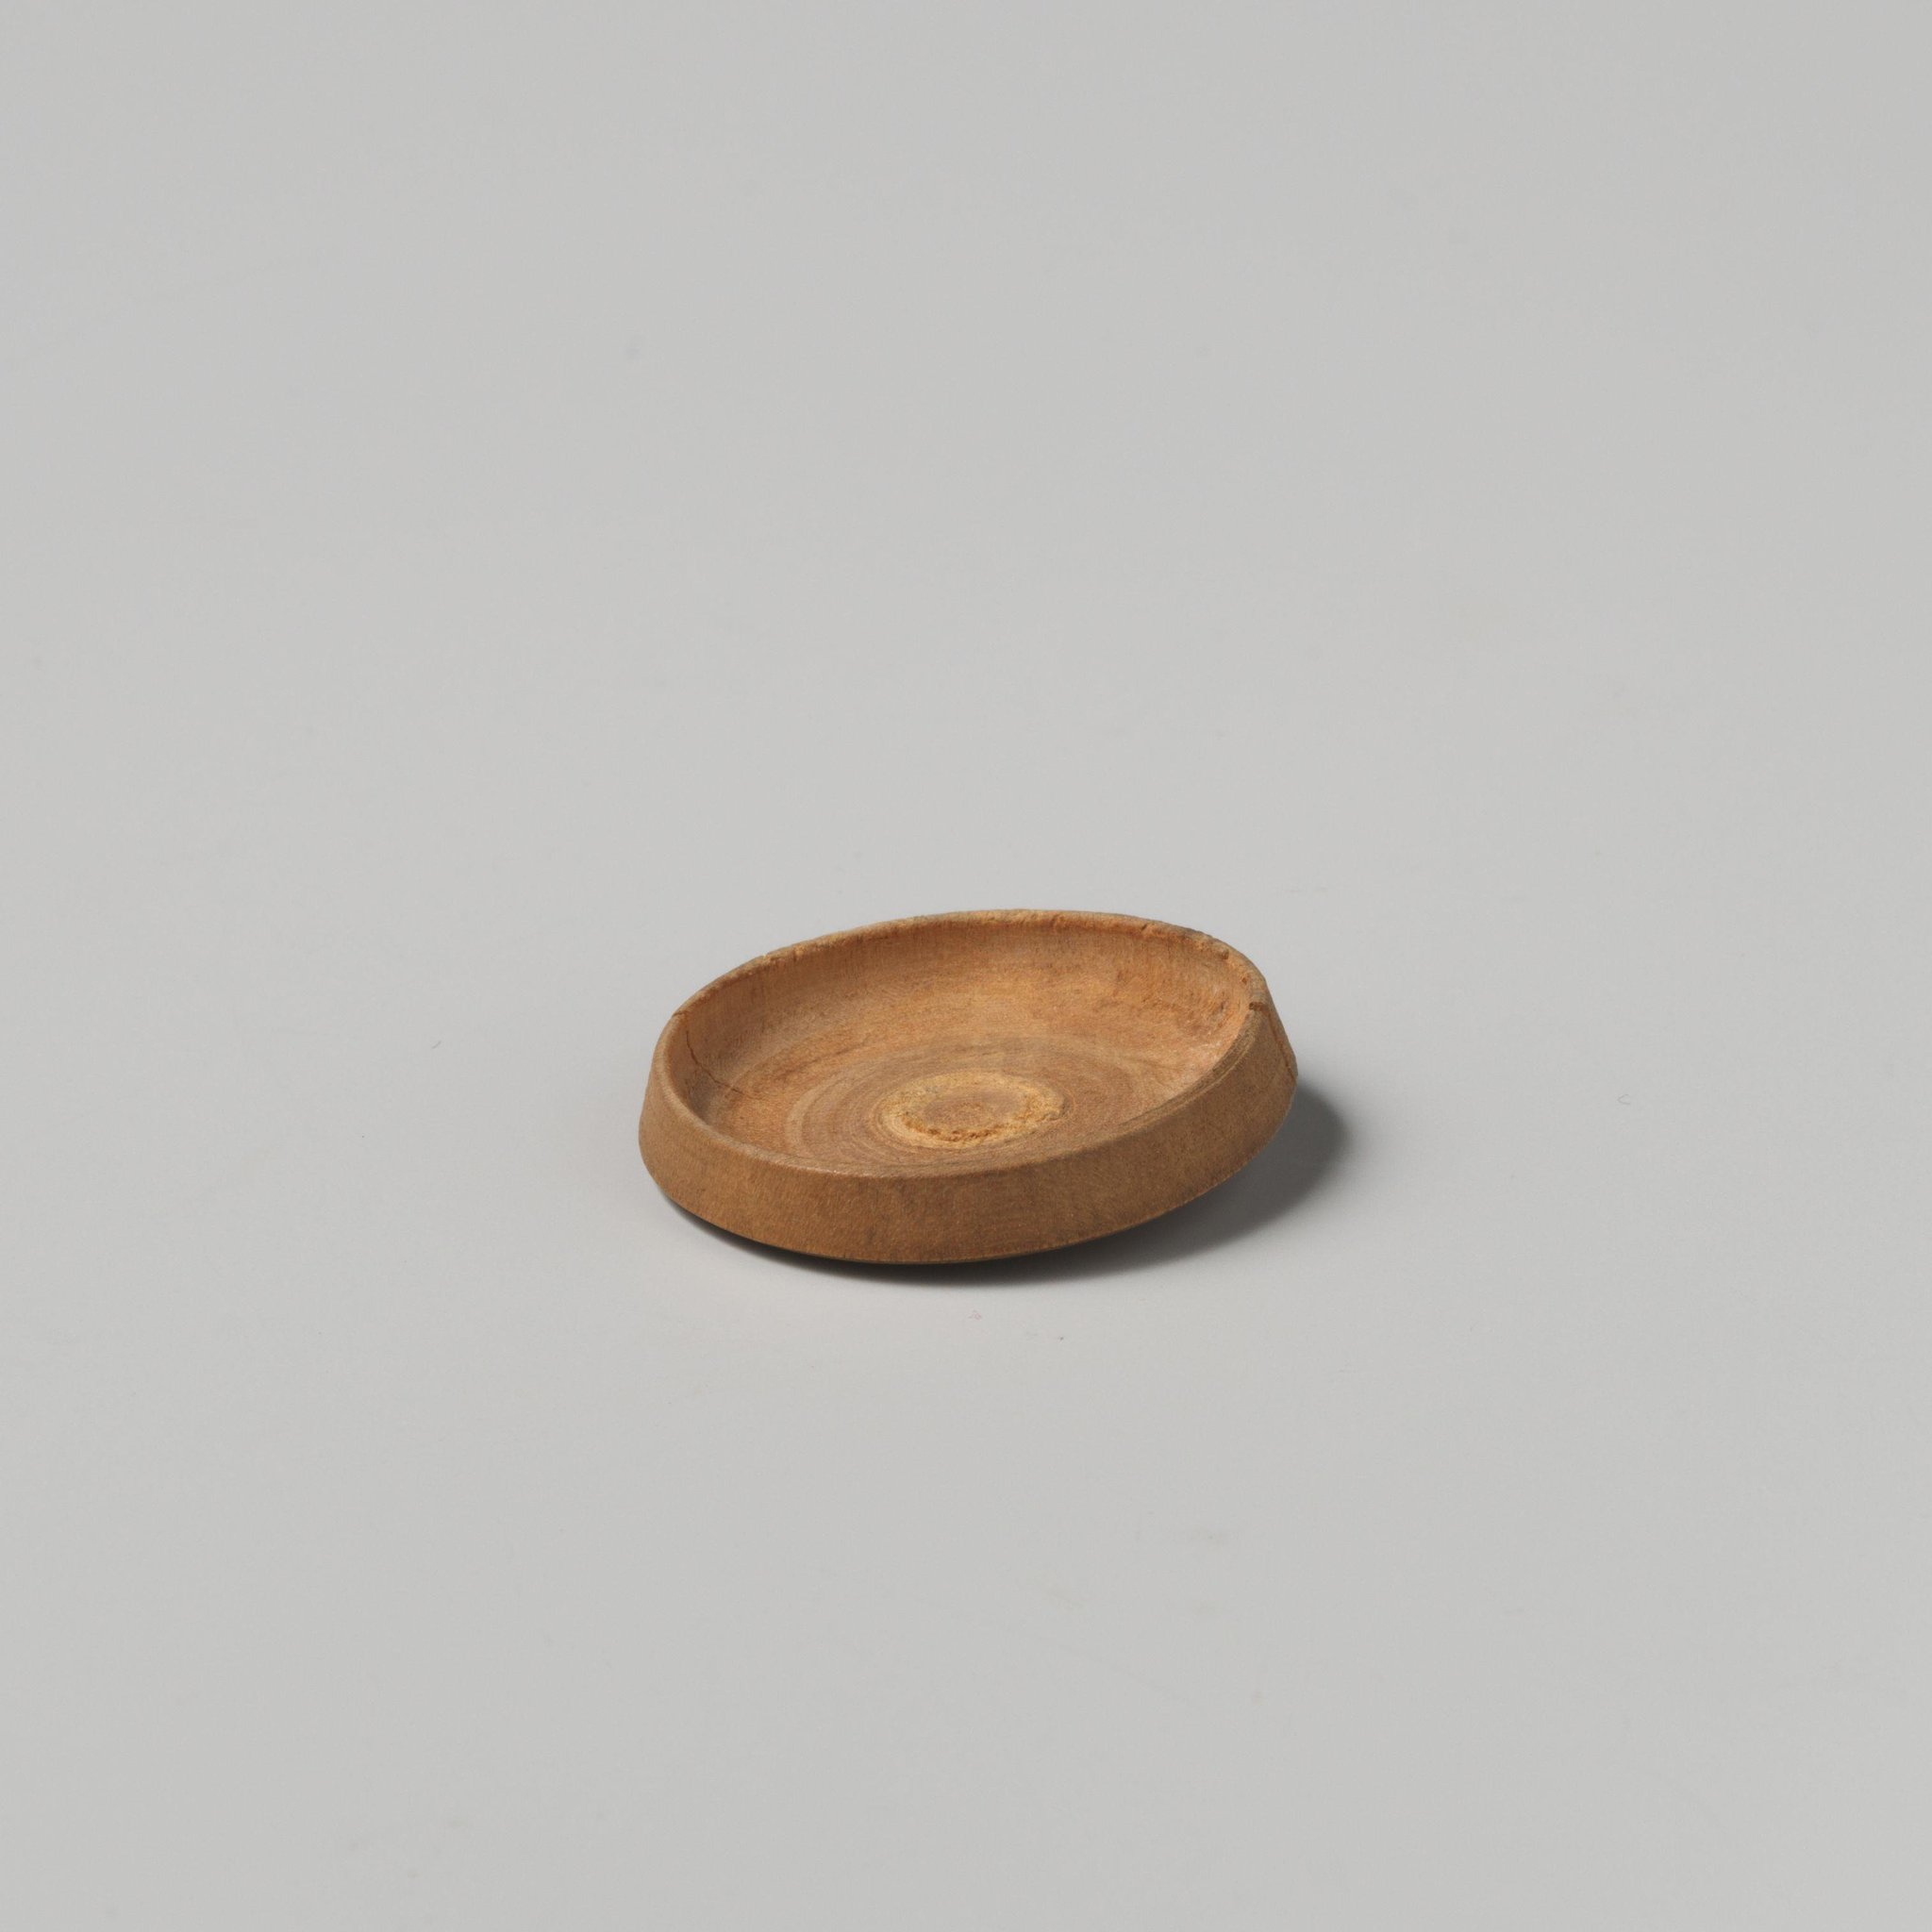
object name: lid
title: Deksel, gedraaid van esdoornhout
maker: Anonymous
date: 1675-1699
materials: wood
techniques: turning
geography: amsterdam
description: Deksel, met platte bovenkant, gedraaid van esdoornhout.